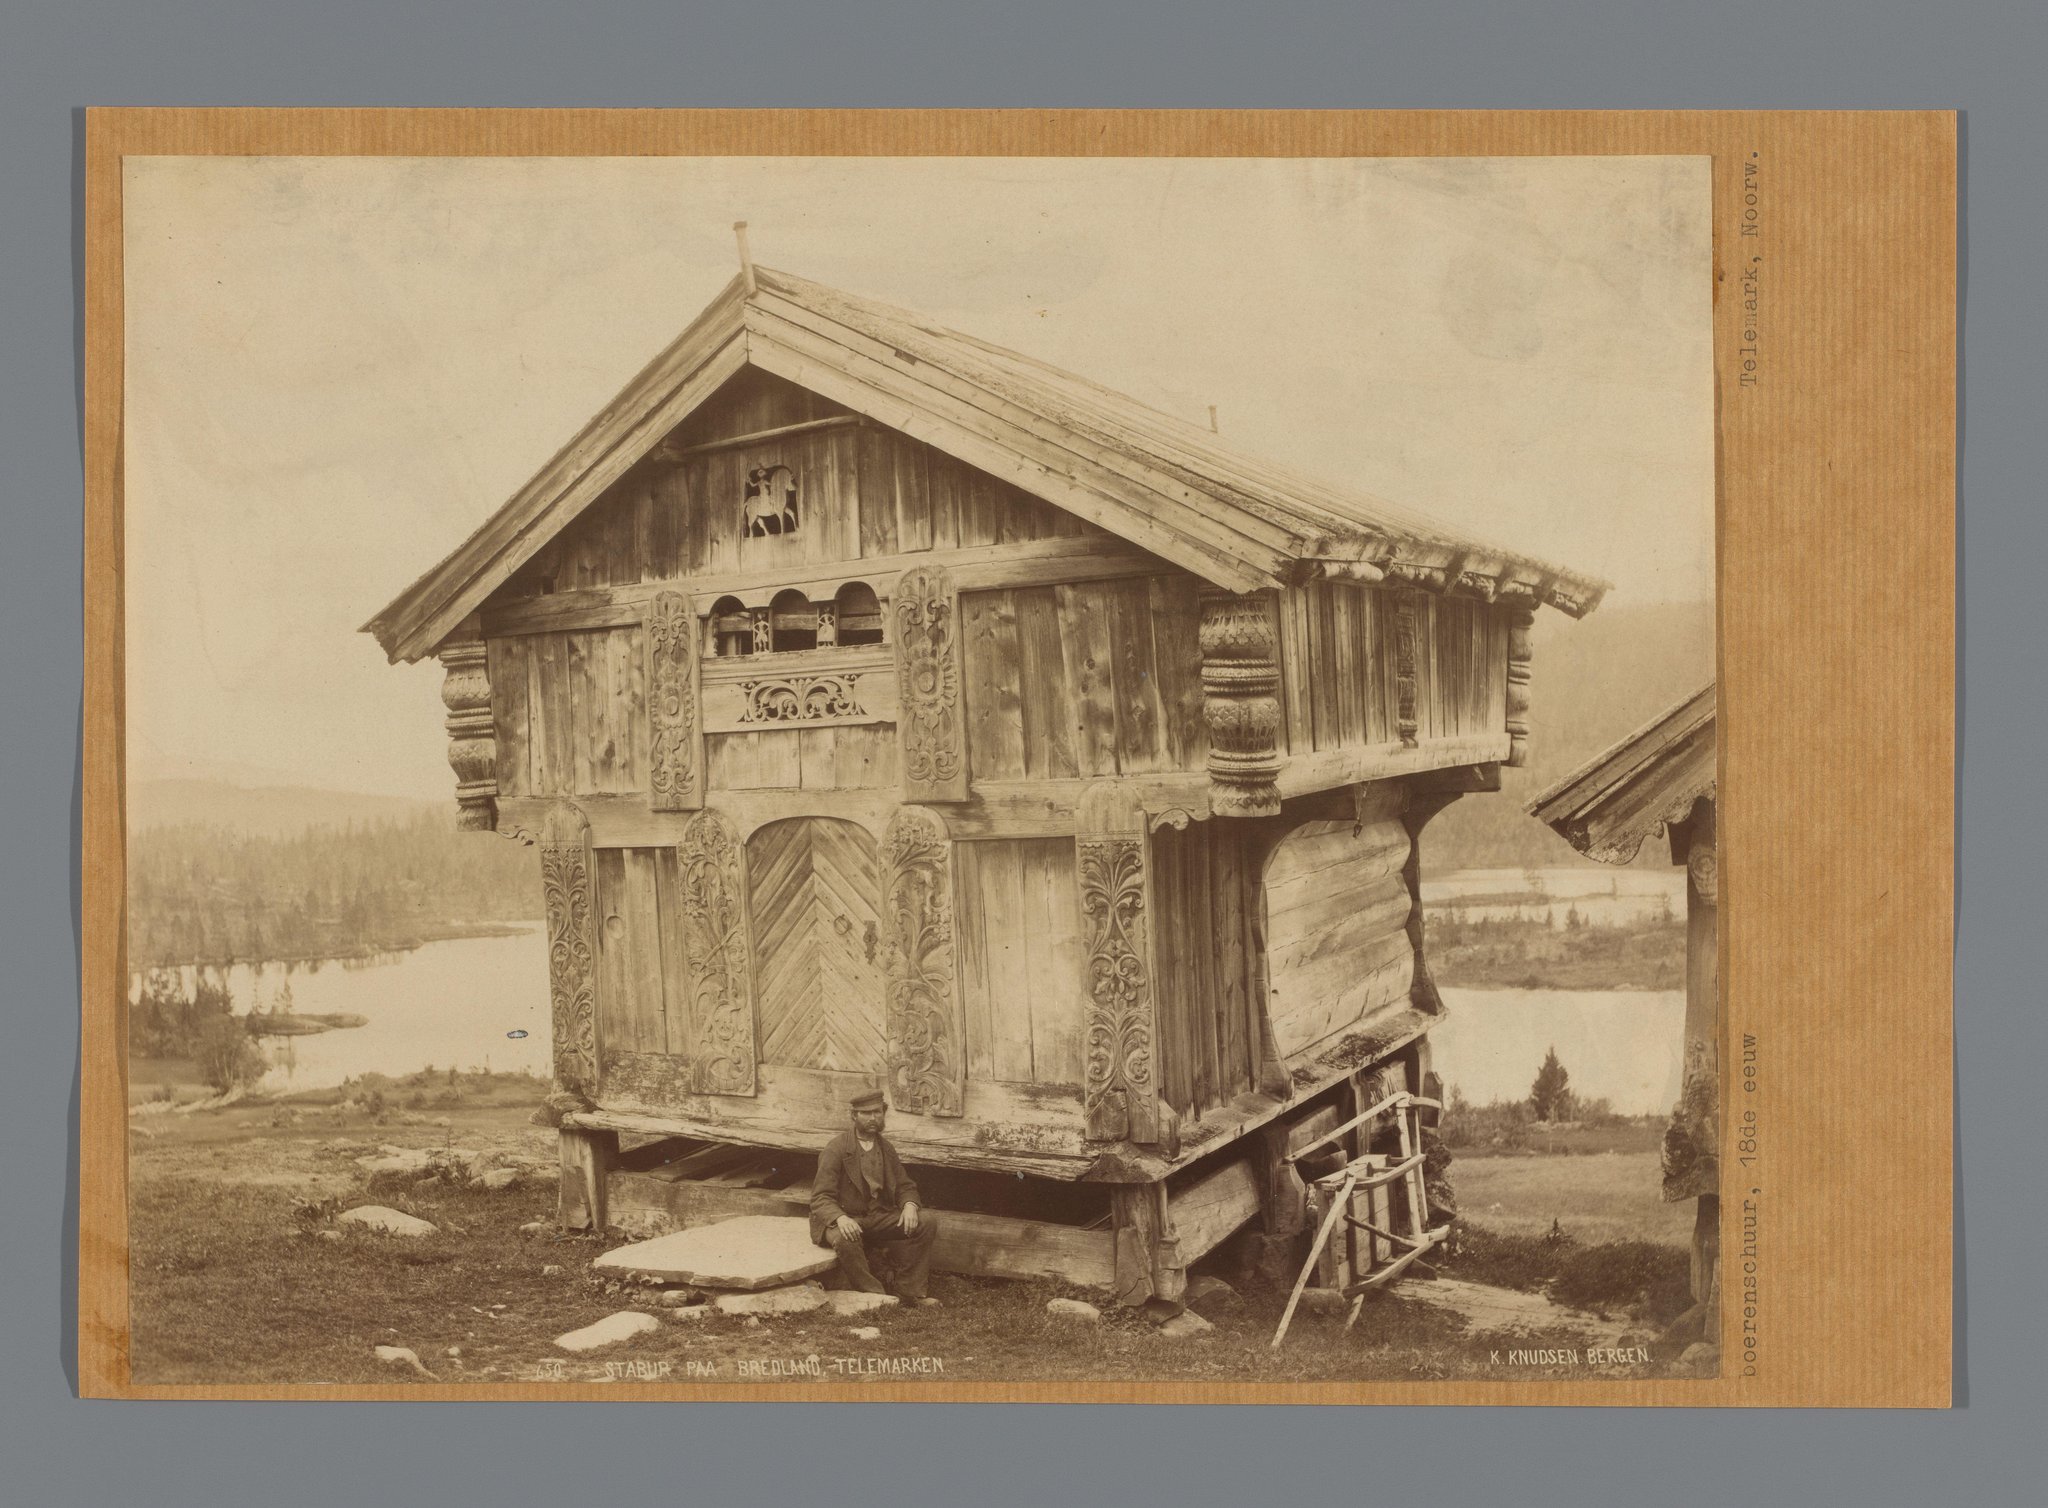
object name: photograph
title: boerenschuur. Telemark. Noorwegen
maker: Anonymous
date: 1850-1900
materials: photographic support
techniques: albumen print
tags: telemark